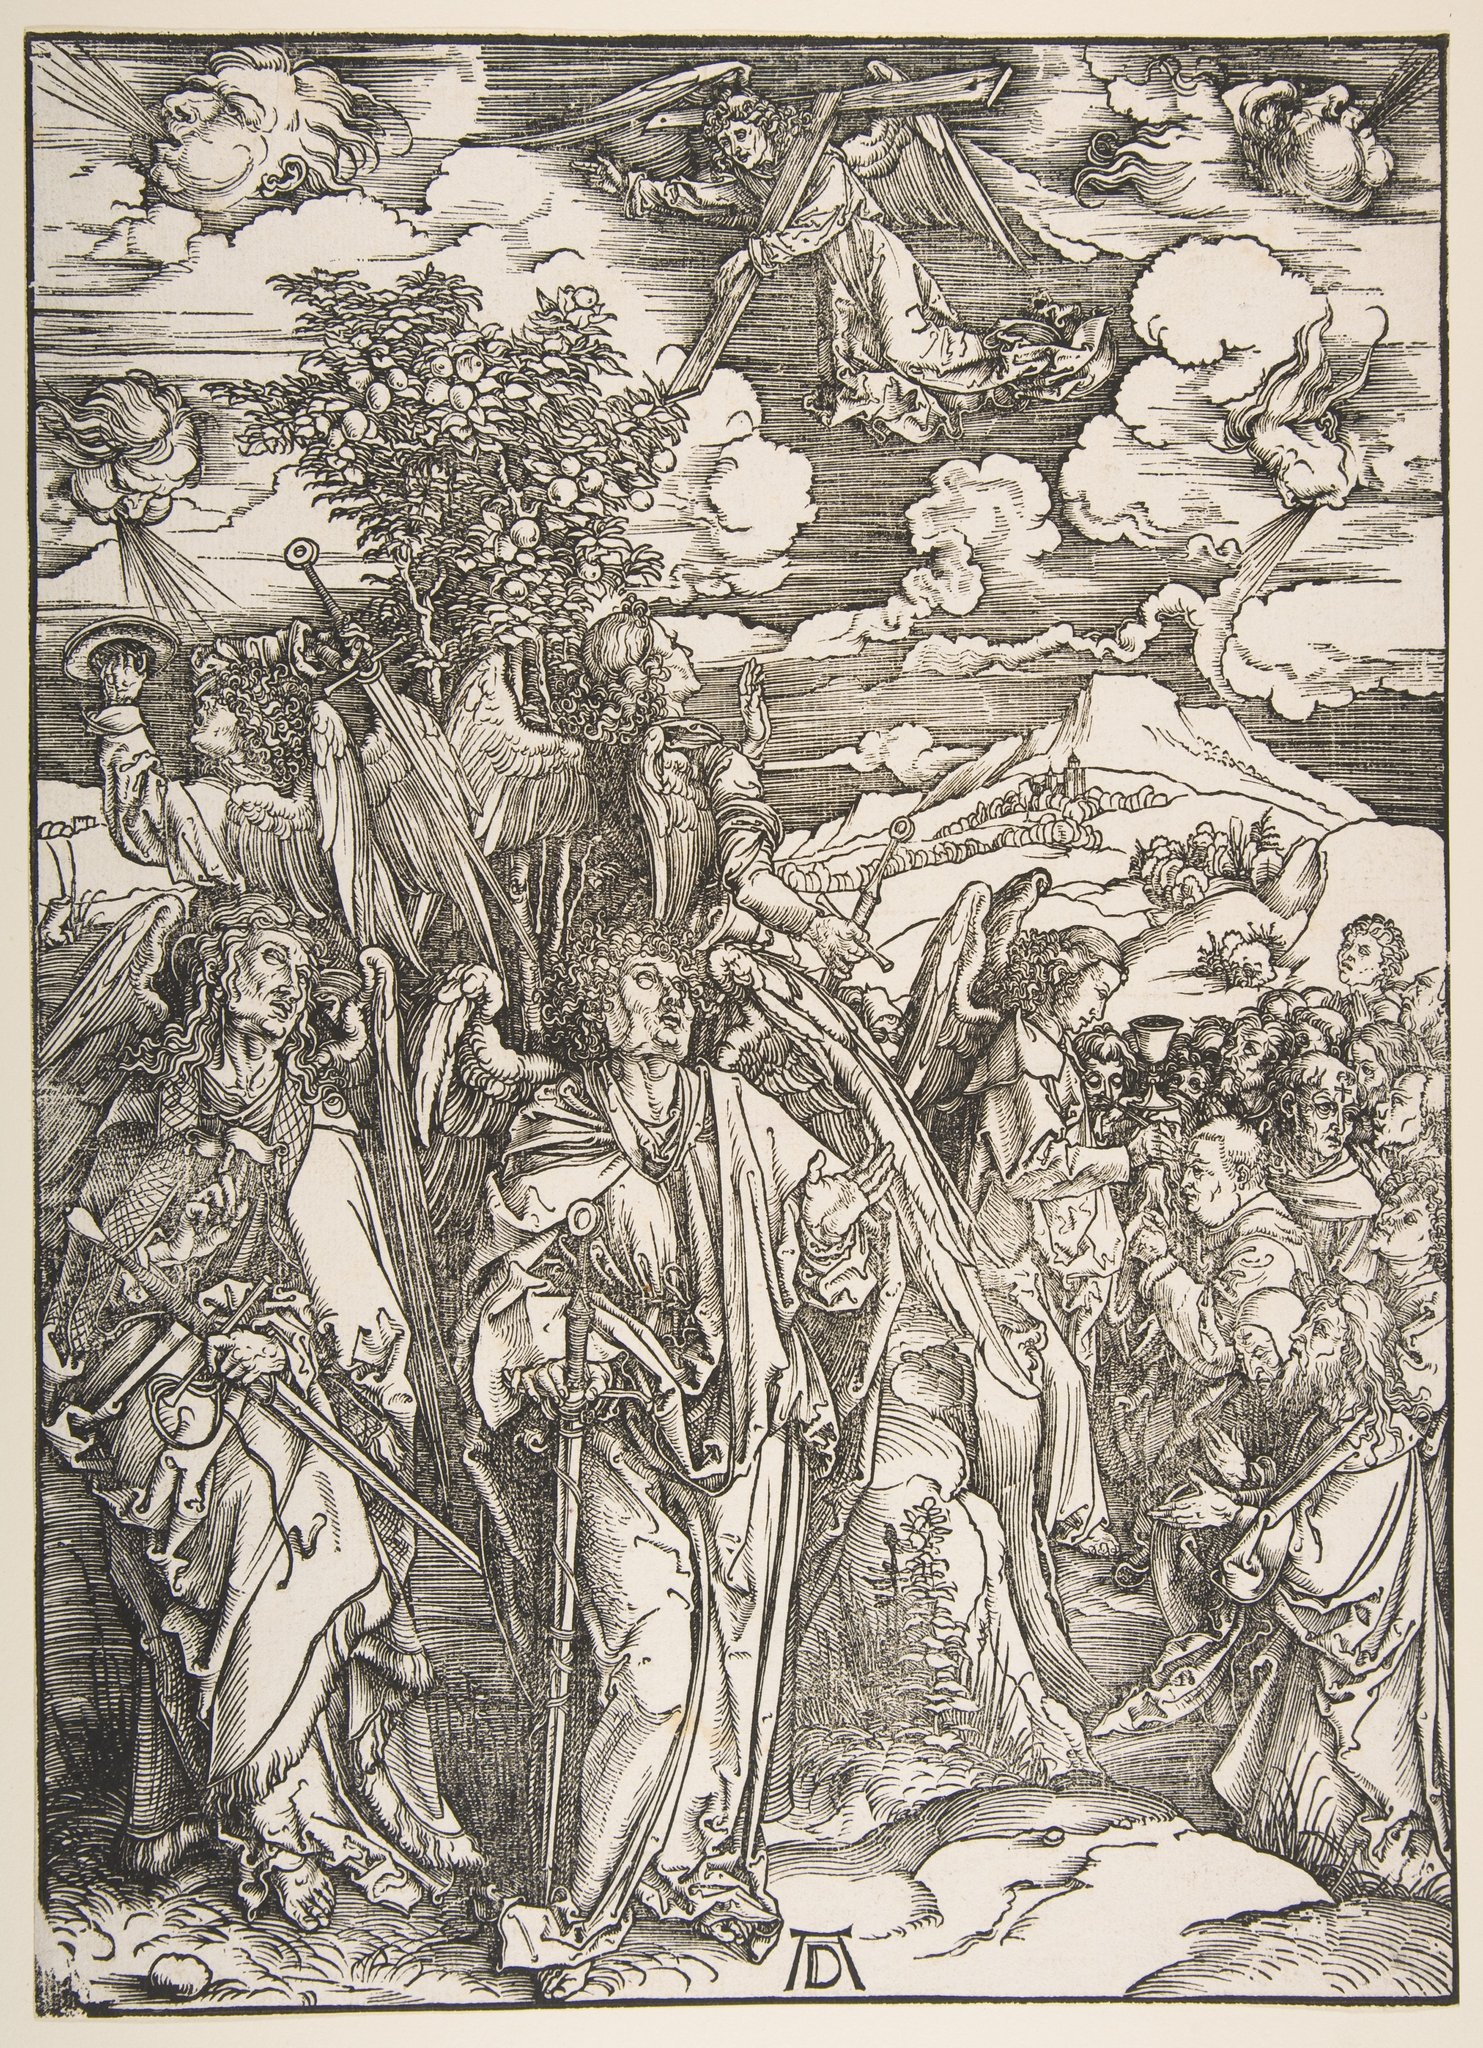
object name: print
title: Angels Restraining the Four Winds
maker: albrecht dürer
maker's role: artist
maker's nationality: german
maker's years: 1471-1528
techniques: woodcut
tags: men,wind,angels